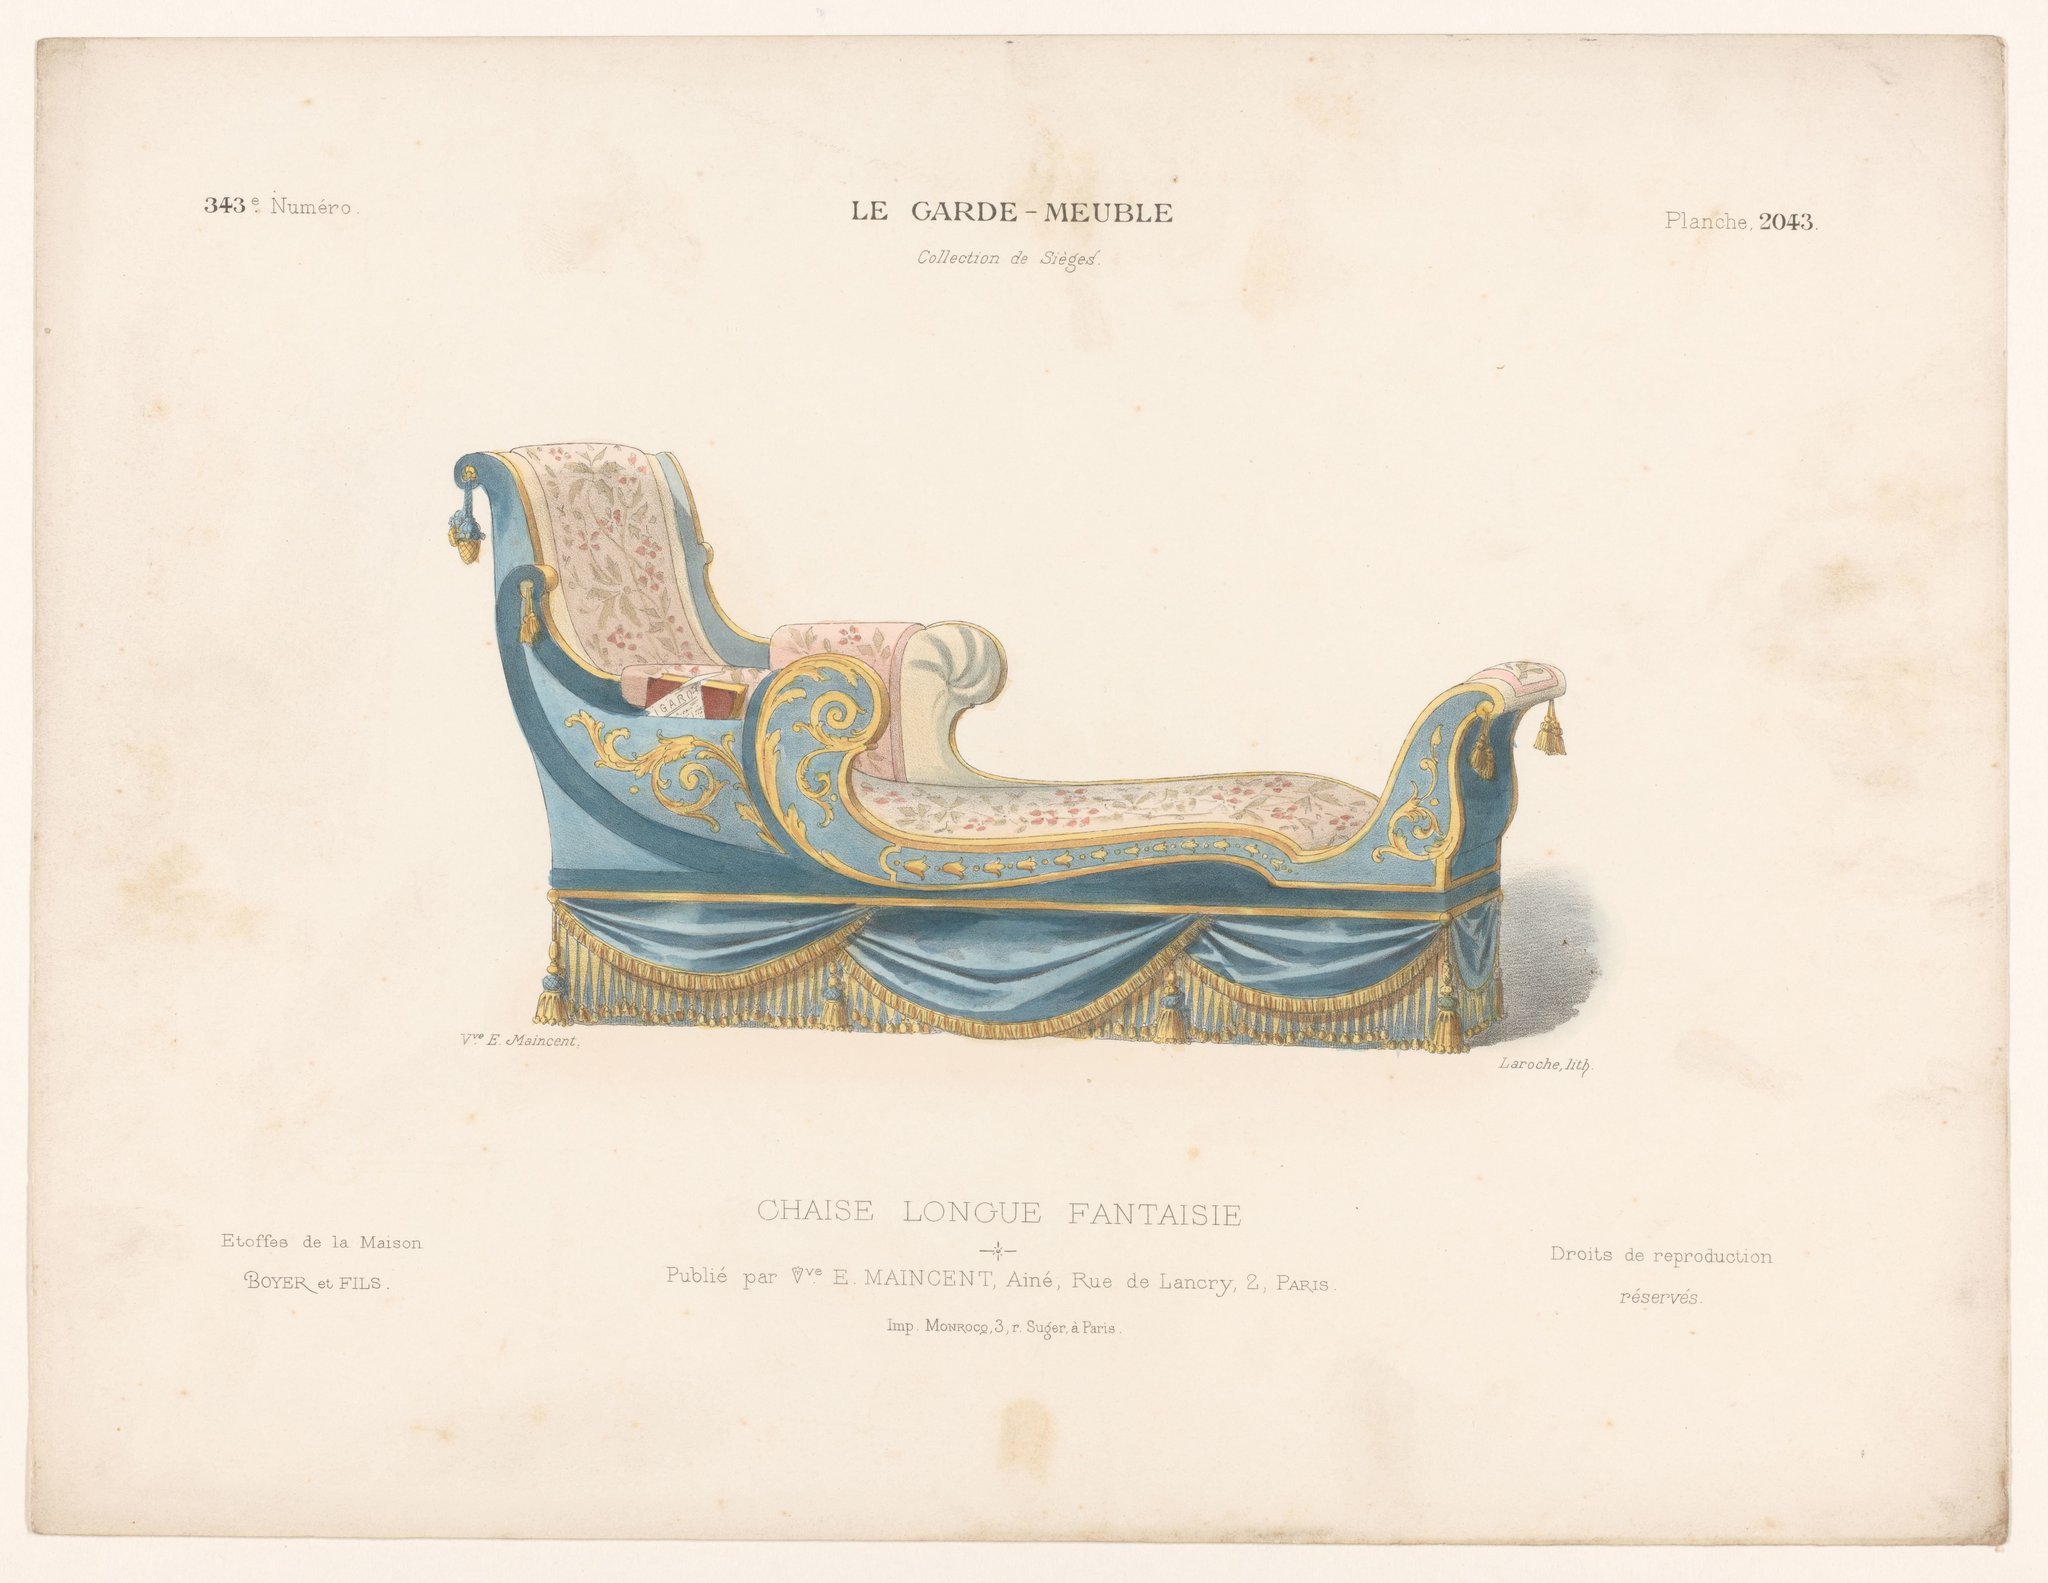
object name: print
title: Chaise longue fantaisie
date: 1895-1935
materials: paper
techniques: hand coloring, lithograph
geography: paris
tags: seating furniture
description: Ieder Livraison in de serie Le Garde-Meuble bevat negen platen: drie 'sièges' (zitmeubels), drie 'meubles' (diverse meubels zoals tafels en kasten) en drie 'tentures' (gordijnen en draperieën).